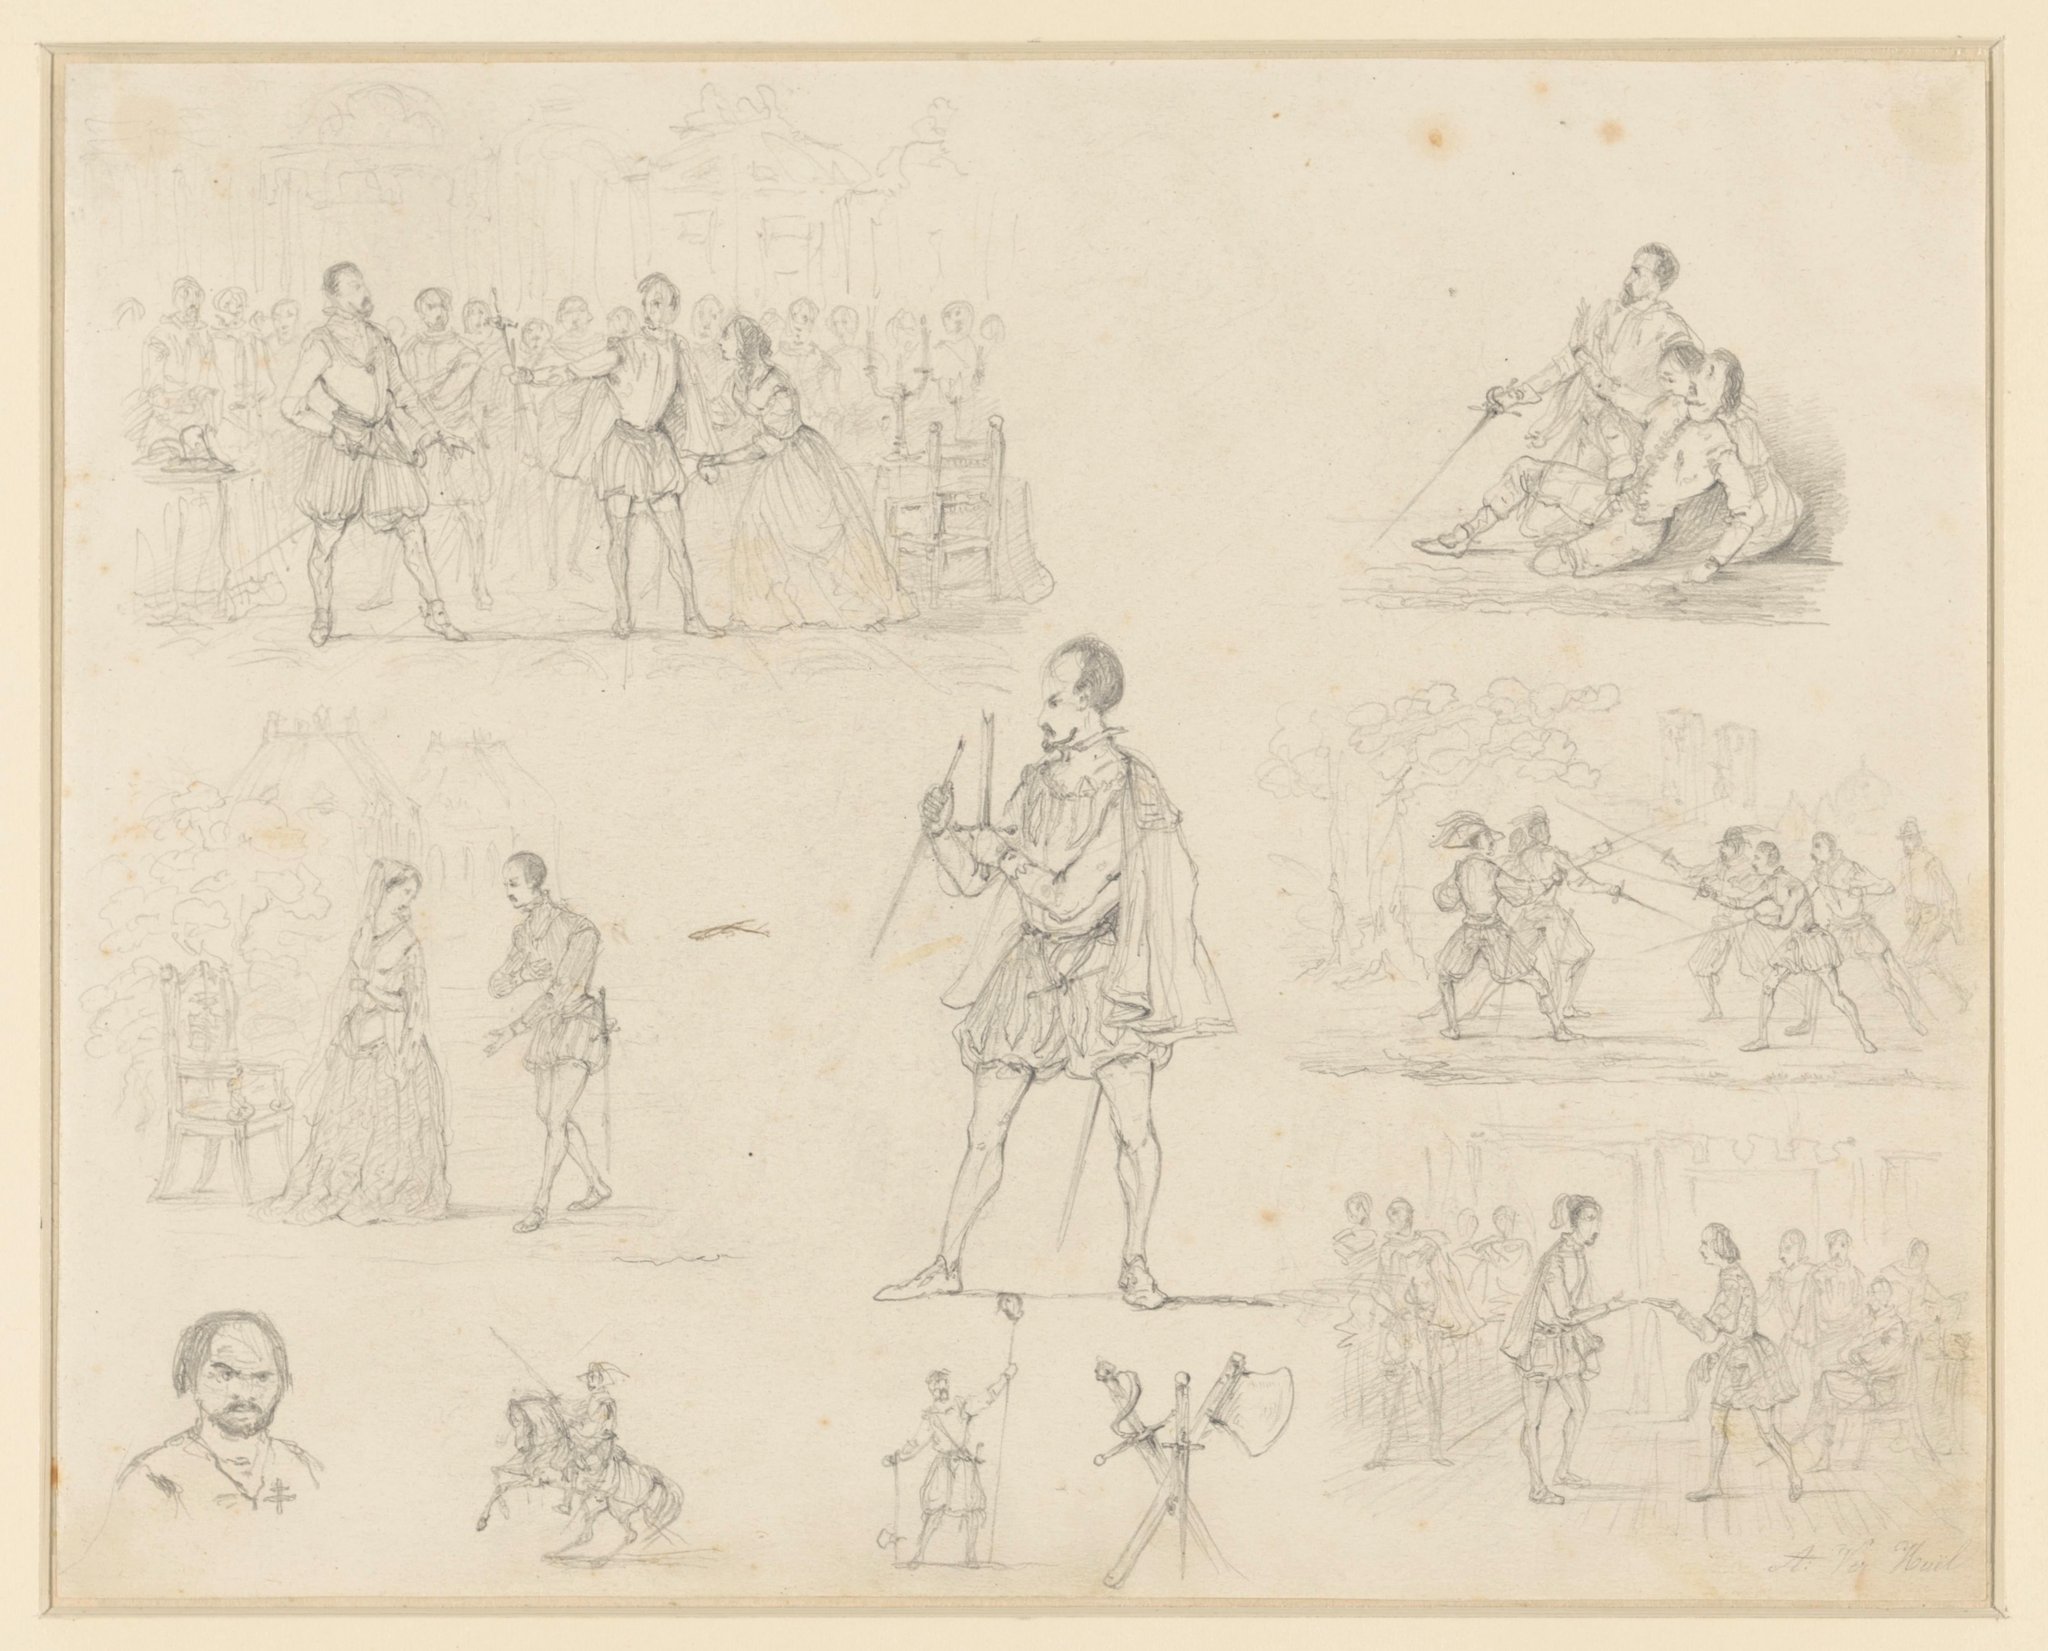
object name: drawing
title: Schetsen van figuren in Spaans kostuum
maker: alexander ver huell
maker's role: draughtsman, print maker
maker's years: 1822-1897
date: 1832-1897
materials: paper, pencil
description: Schetsblad met illustraties voor een roman.